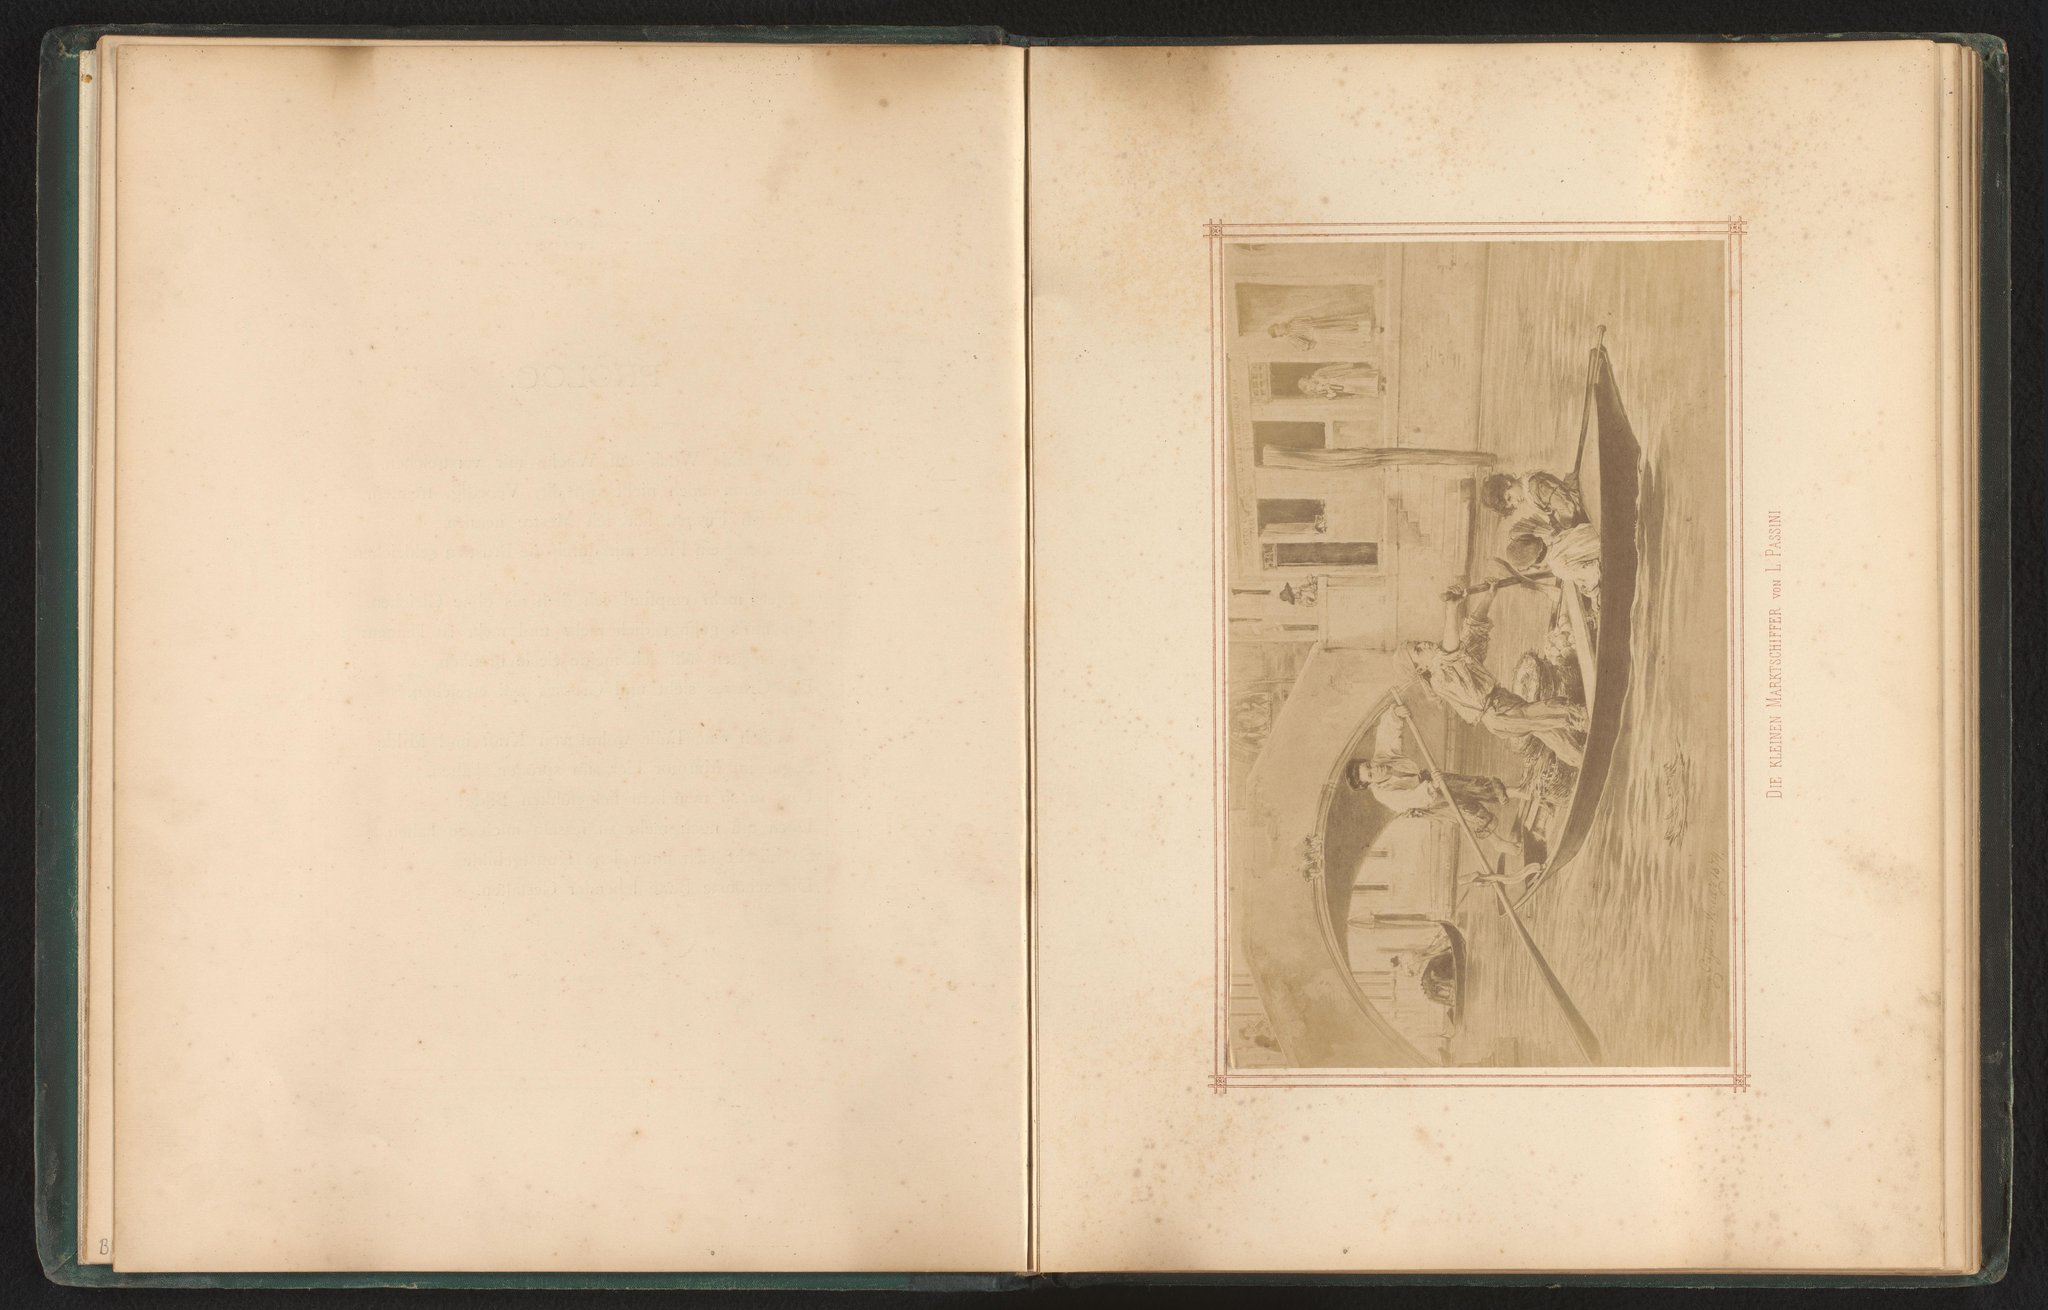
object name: reproduction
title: Fotoreproductie van een schilderij van vier kinderen op een gondel in het Canal Grande van Venetië door Ludwig Johann Passini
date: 1874-1875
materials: paper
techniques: albumen print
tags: canals, waters (in city), picture, painting, gondola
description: Foto op tweede ongenummerde pagina voor pagina 1.